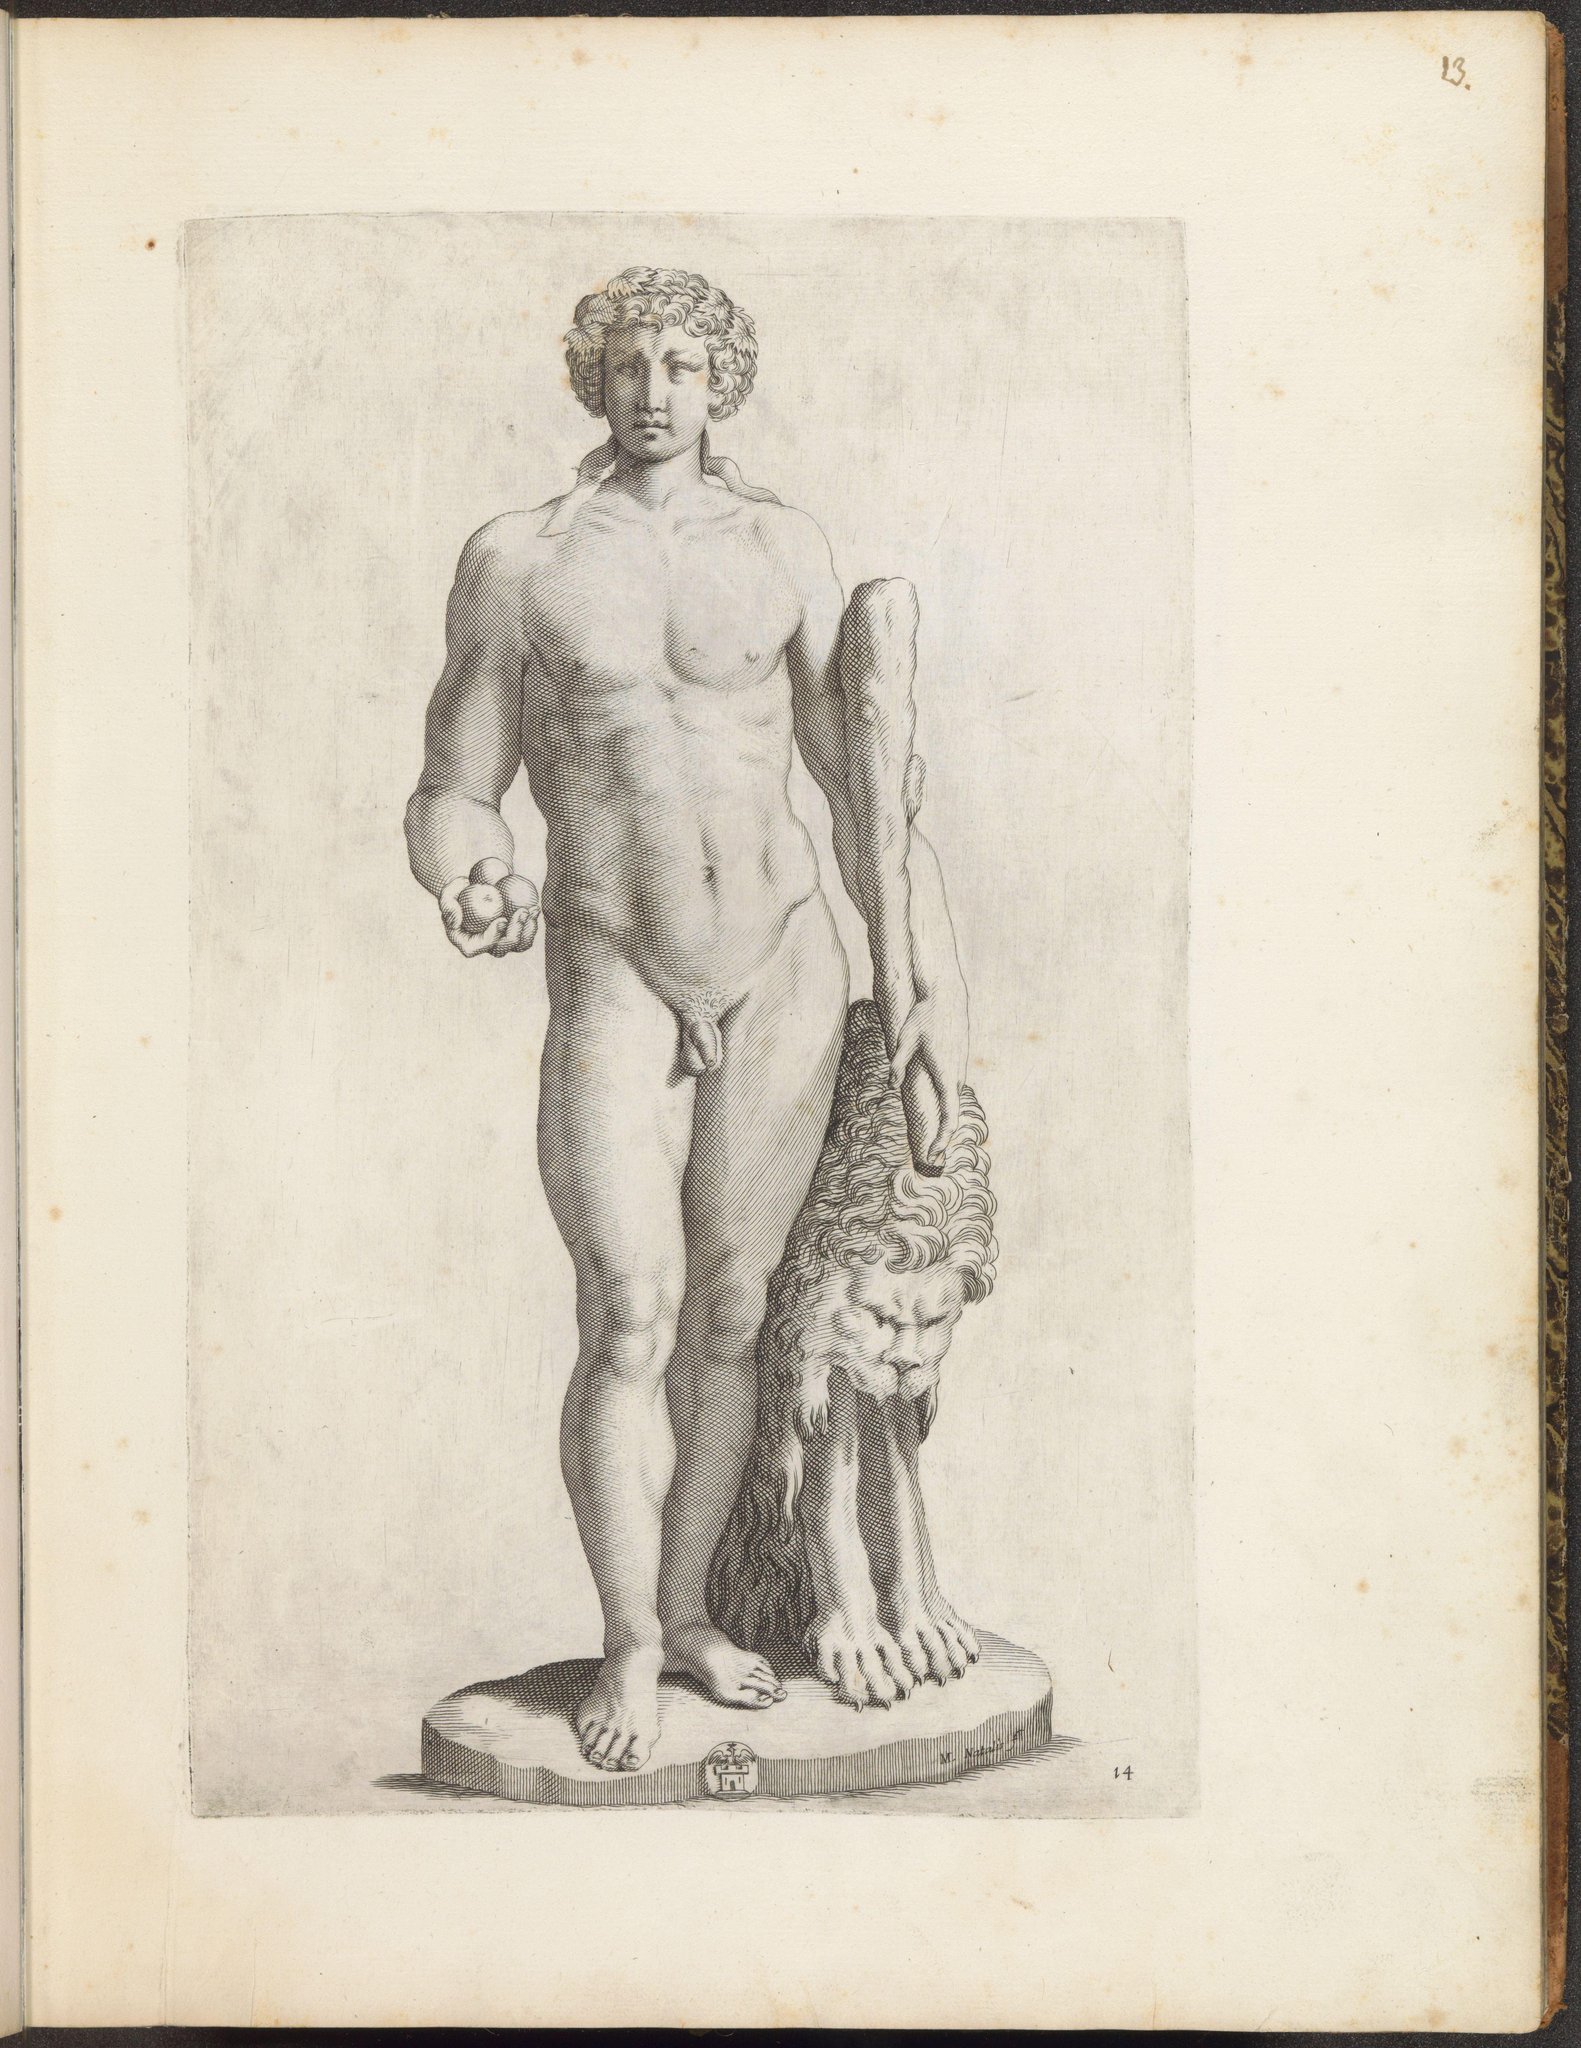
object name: print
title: Galleria Giustiniana del Marchese Vincenzo Giustiniani I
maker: michel natalis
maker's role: print maker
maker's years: 1610-1668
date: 1636-1647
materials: paper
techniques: engraving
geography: rome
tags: (story of) hercules (heracles), attributes of hercules (with name), piece of sculpture, reproduction of a piece of sculpture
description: Standbeeld van Hercules met de appelen van de Hesperiden in zijn linkerhand, de knots in zijn rechterhand. Naast hem de huid van de leeuw. Op de basis het wapenschild van Vincenzo Giustiniani. Prent maakt deel uit van een album met een serie prenten naar de sculpturen in de verzameling in de Galleria Giustiniani te Rome.